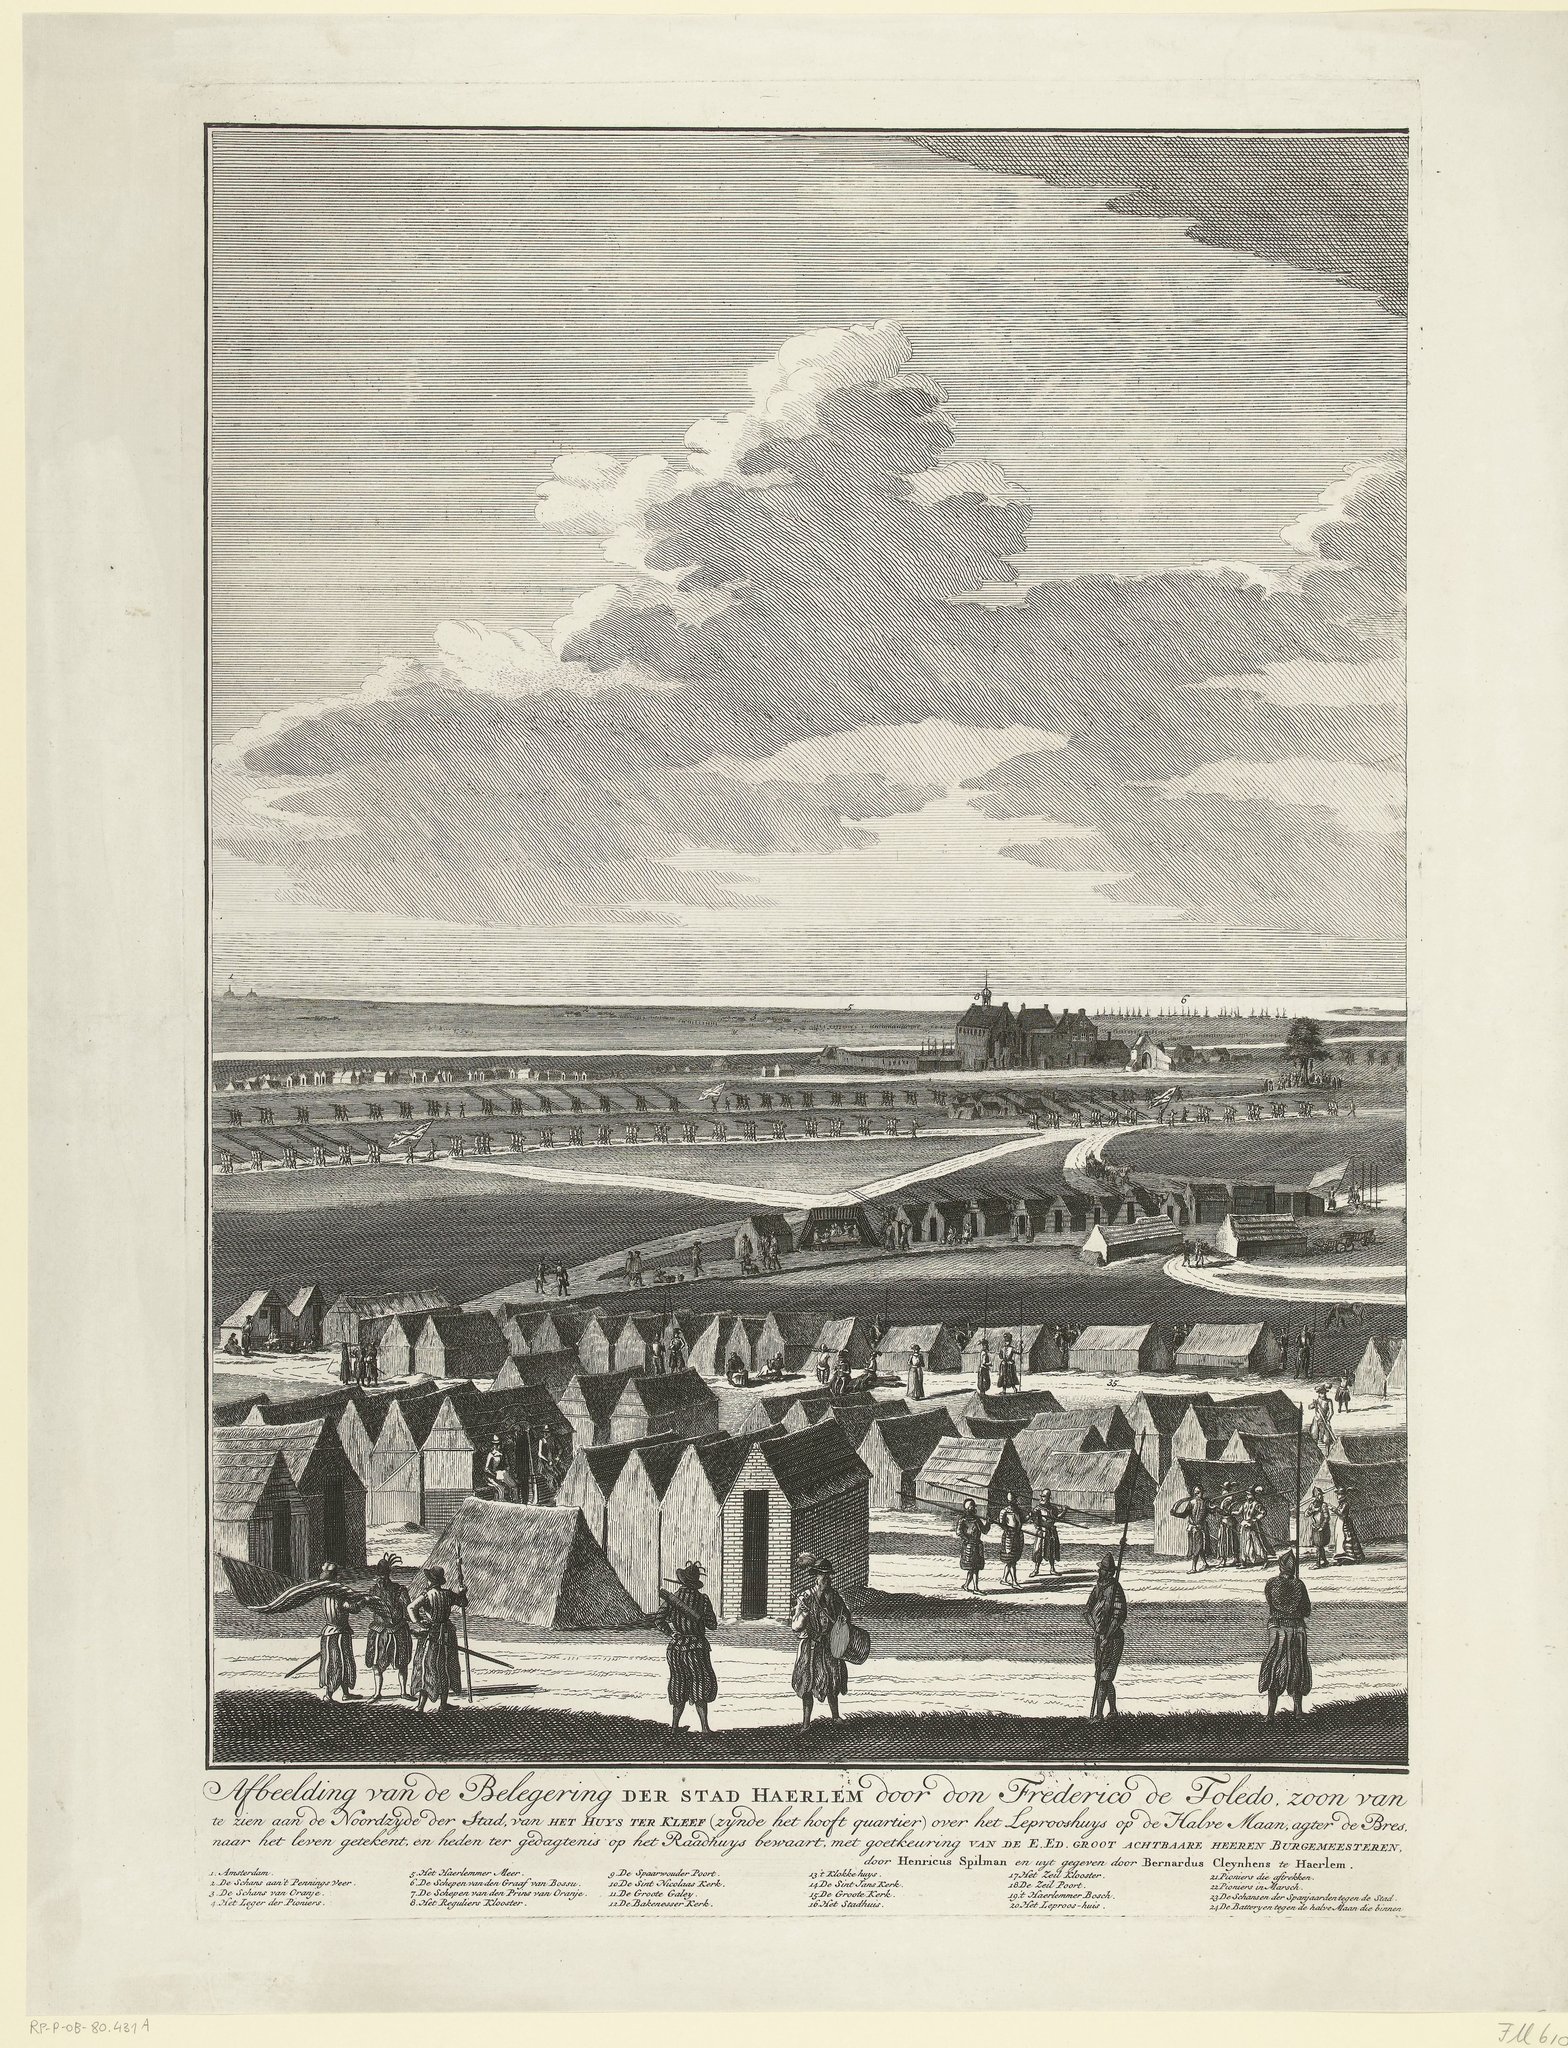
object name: print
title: Afbeelding van de Belegering der stad Haerlem door don Frederico de Toledo, zoon van den Hertog van Alva in de jaare 1572 en 1573, te zien aan de noordzyde der stad, van het Huys ter Kleef (zynde het hooft quartier) over het Leprooshuys op de Halve Maan, agter de Bres, in de stads muuren, en de schansen der Spanjaarden, in die tijd naar het leven getekent (...) / Vue du Siege de la ville de Haerlem par Don Frederic de Tolede, fils du Duc d'Albe l'année 1572 & 1573 (...)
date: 1742-1779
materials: paper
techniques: etching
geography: haarlem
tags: siege, position war, haarlem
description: Belegering van de stad Haarlem in de jaren 1572-1573 door de Spanjaarden onder Fadrique Alvarez de Toledo (Don Frederik), de zoon van de hertog van Alva. Grote voorstelling met een gezicht op de stad vanuit het noorden, in prent naar een eigentijdse tekening in drie bladen, waarvan dit het linkerblad is. Onder de voorstelling de titels en de legenda's 1-35 in het Nederlands en Frans.